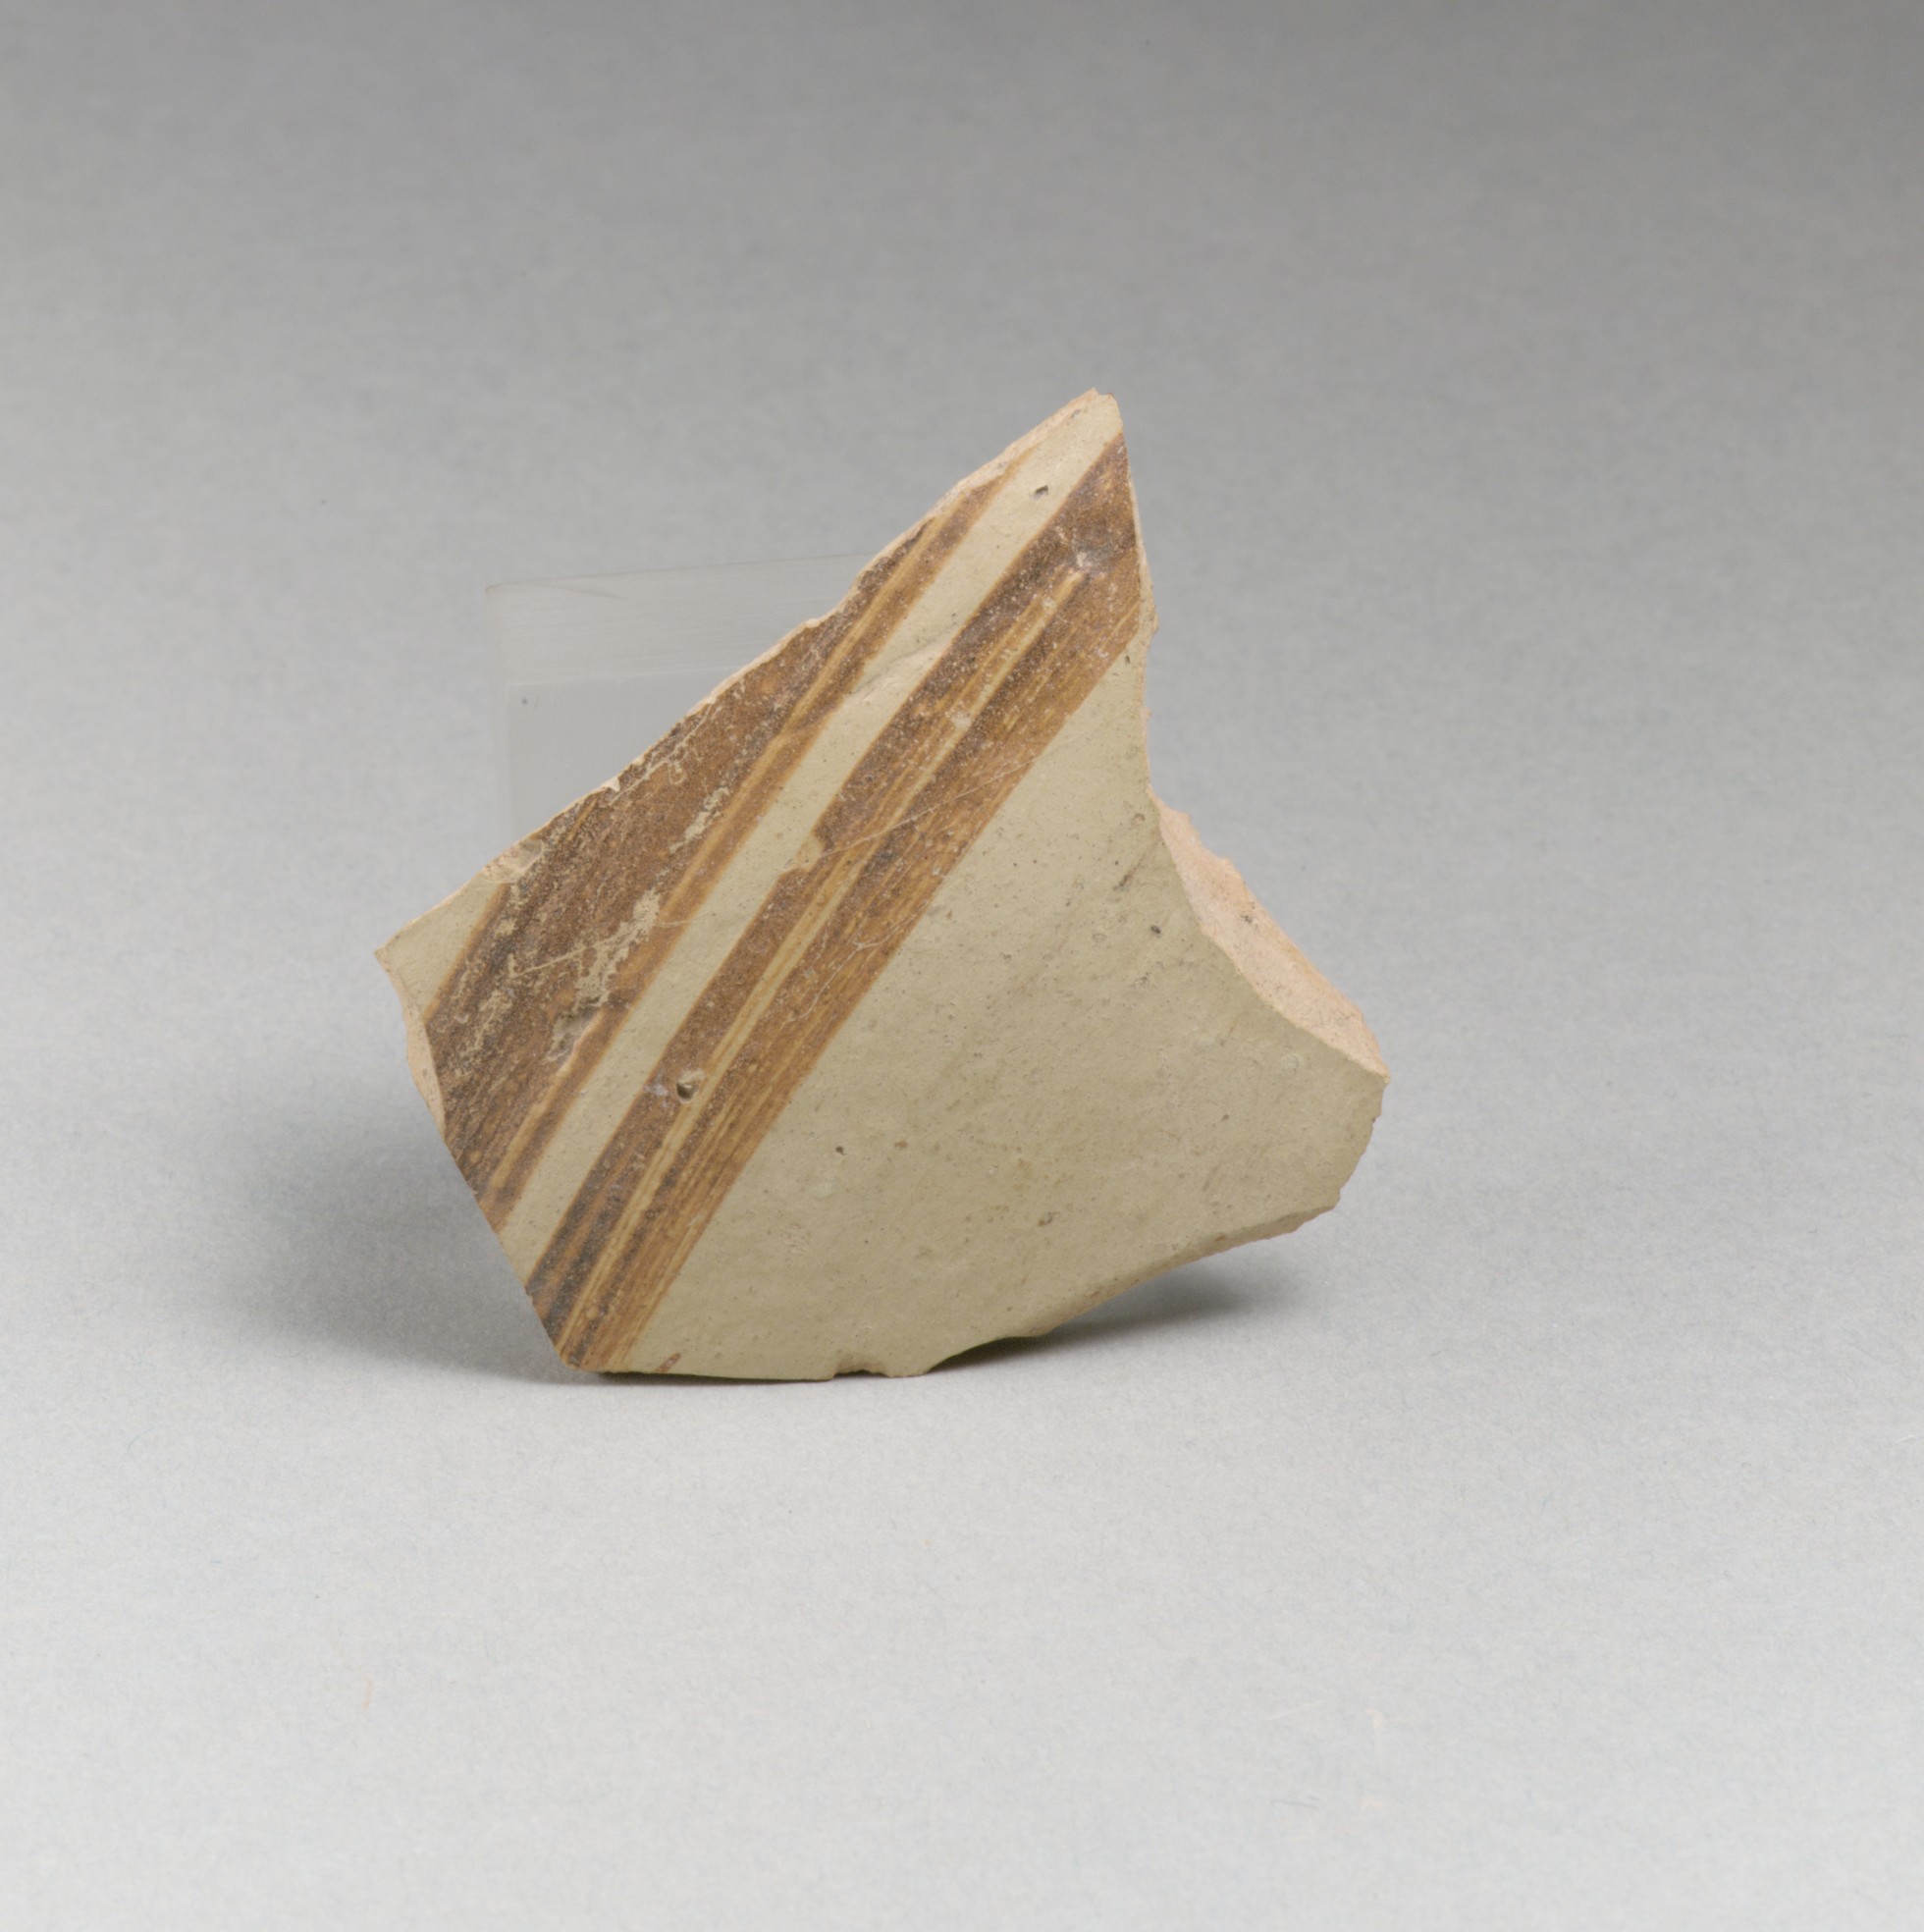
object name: vase fragment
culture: mycenaean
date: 1400-1300 BCE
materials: terracotta